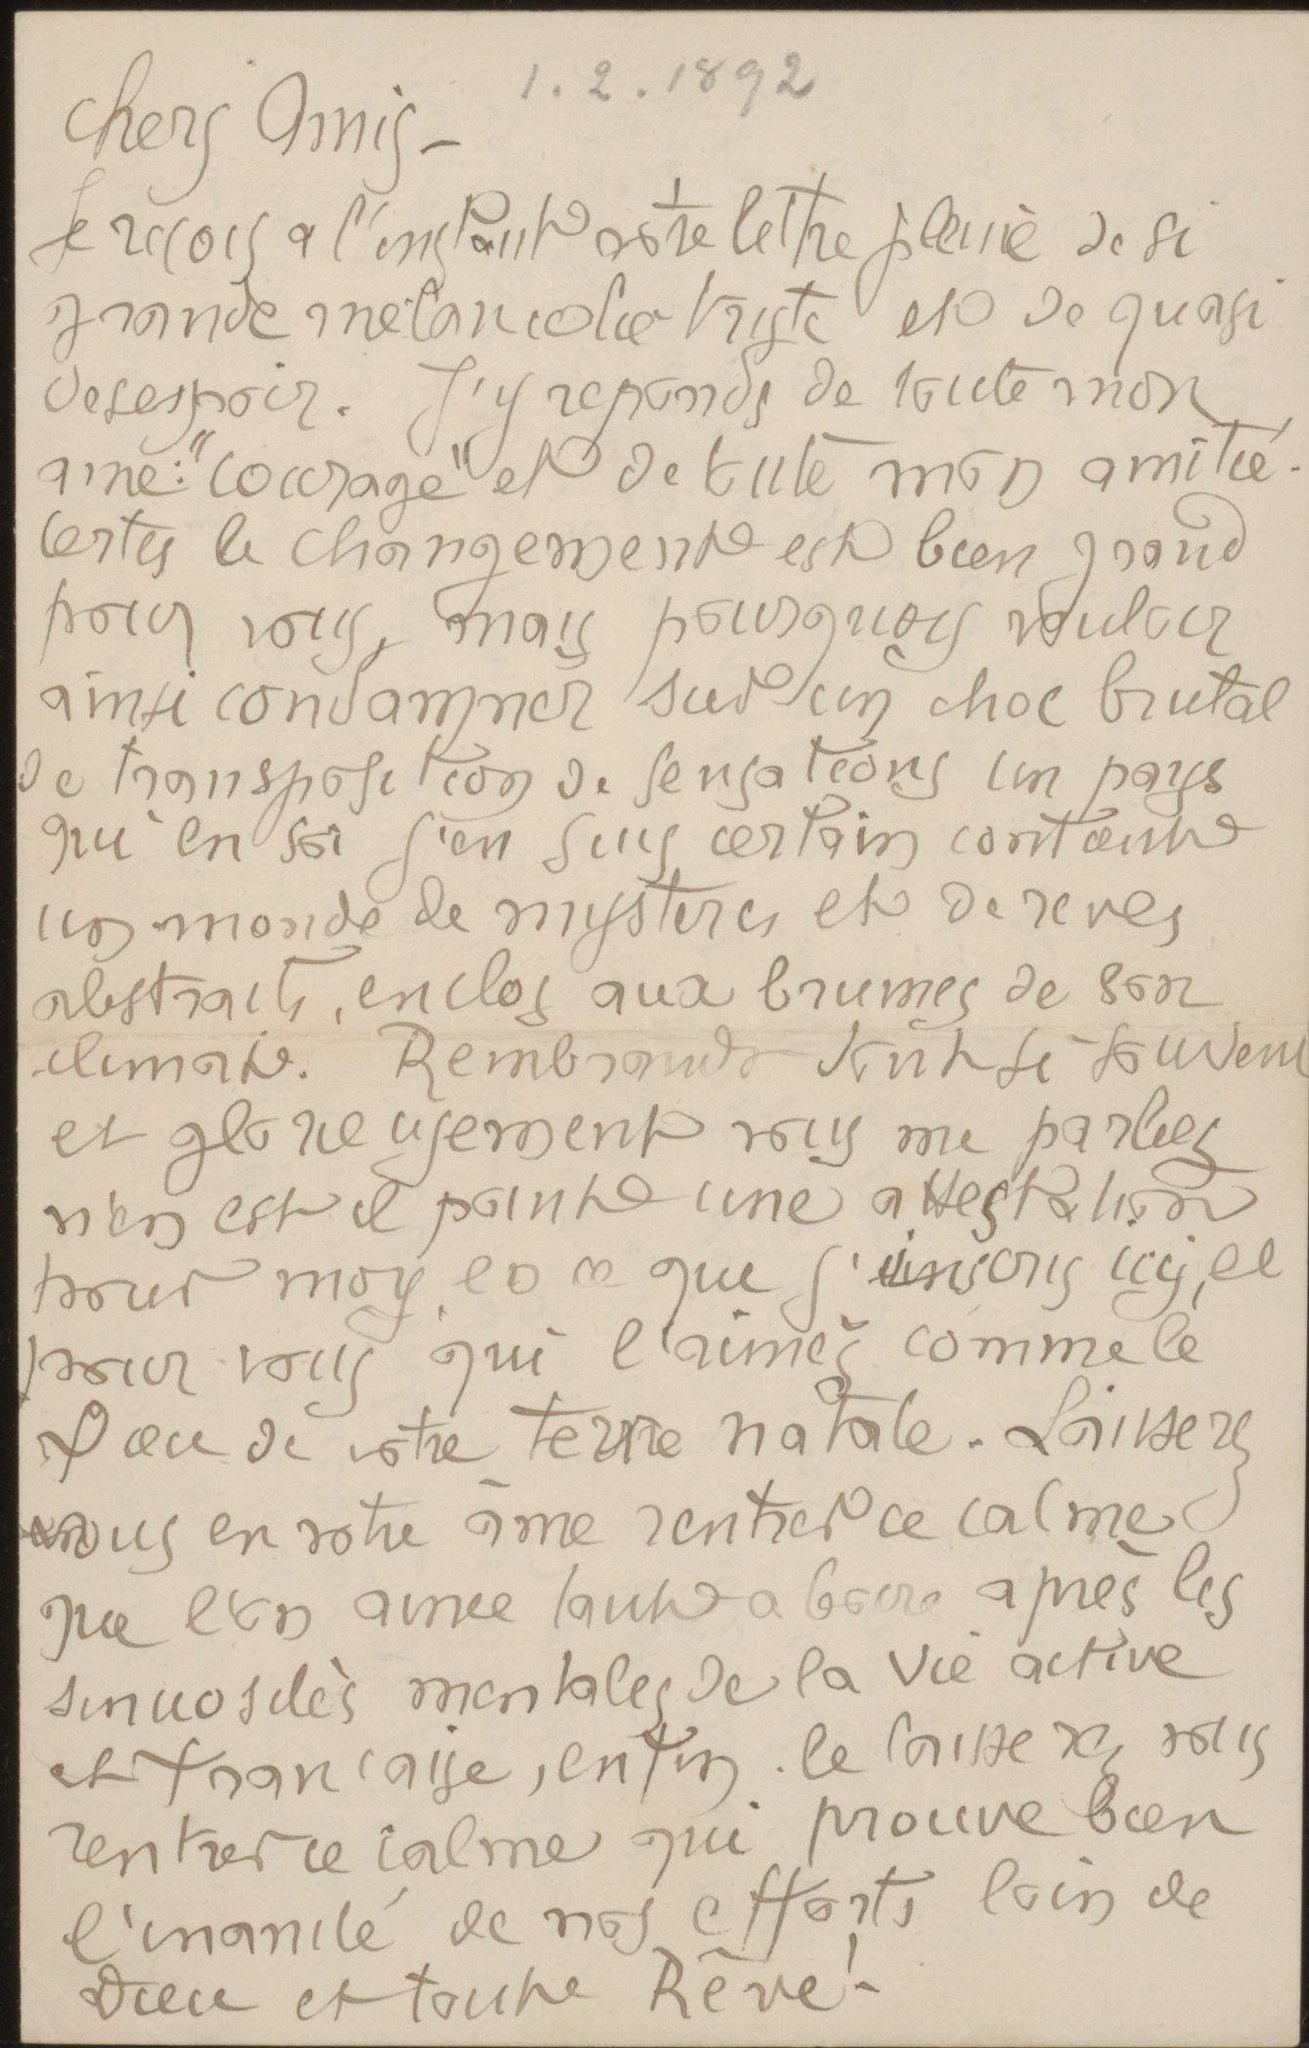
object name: letter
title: Brief aan Andries Bonger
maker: émile bernard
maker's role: print maker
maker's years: 1868-1941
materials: ink, paper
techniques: pen, writing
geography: couilly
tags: painter, andries bonger, drawing, sketch, christian religion